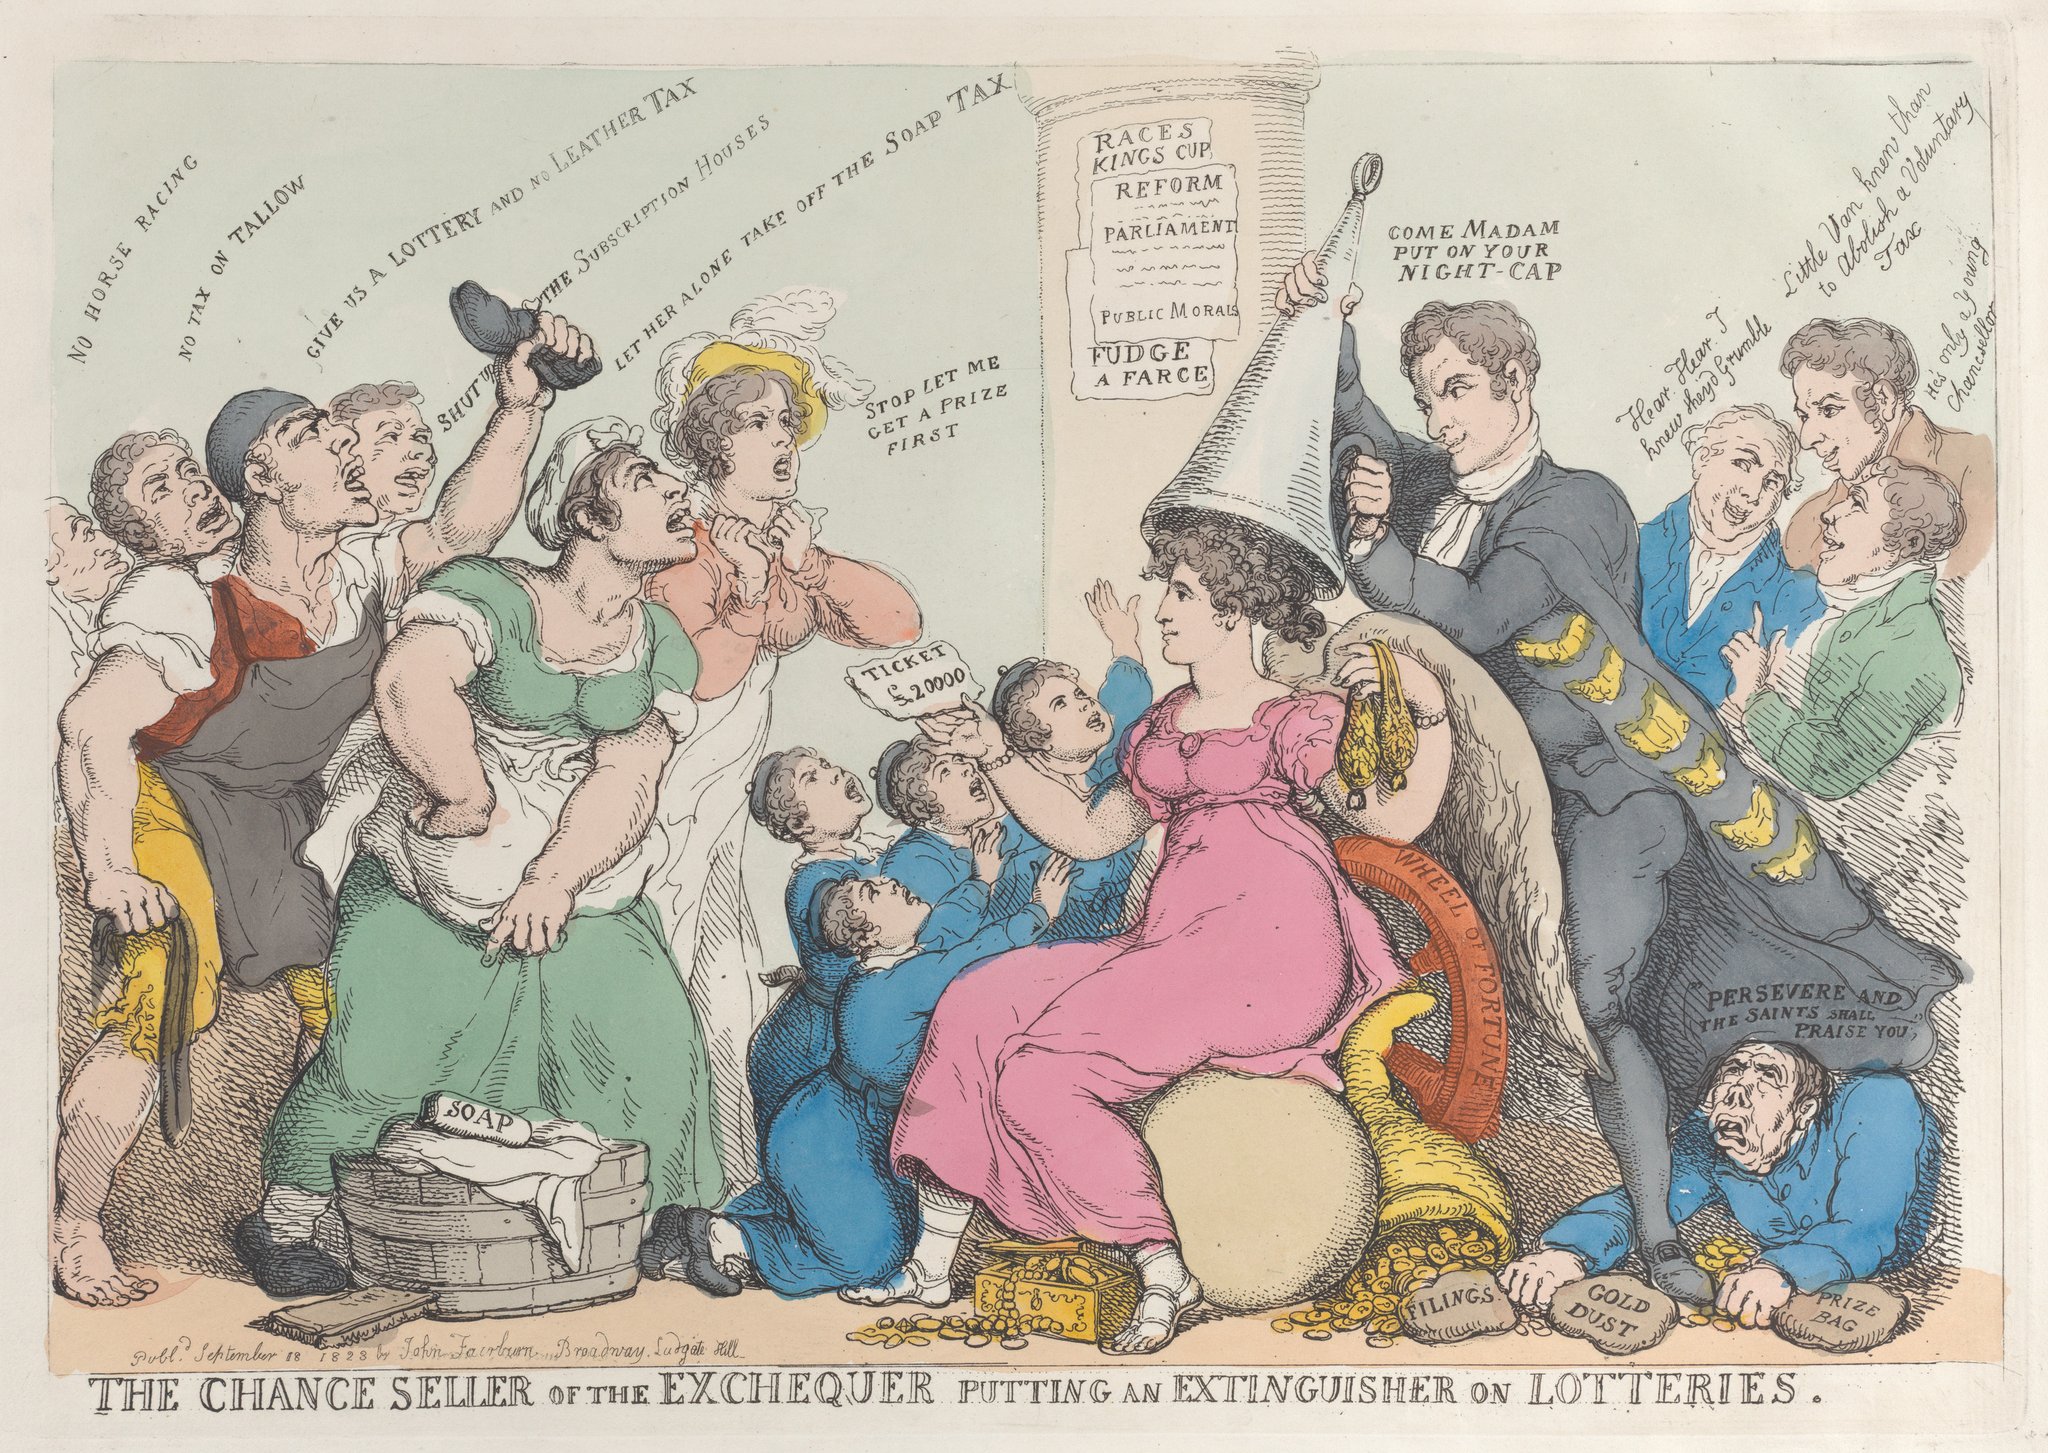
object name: print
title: The Chance Seller of the Exchequer Putting an Extinguisher on Lotteries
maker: thomas rowlandson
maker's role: artist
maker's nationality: british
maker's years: 1757-1827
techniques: etching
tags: satire,men,women,politics